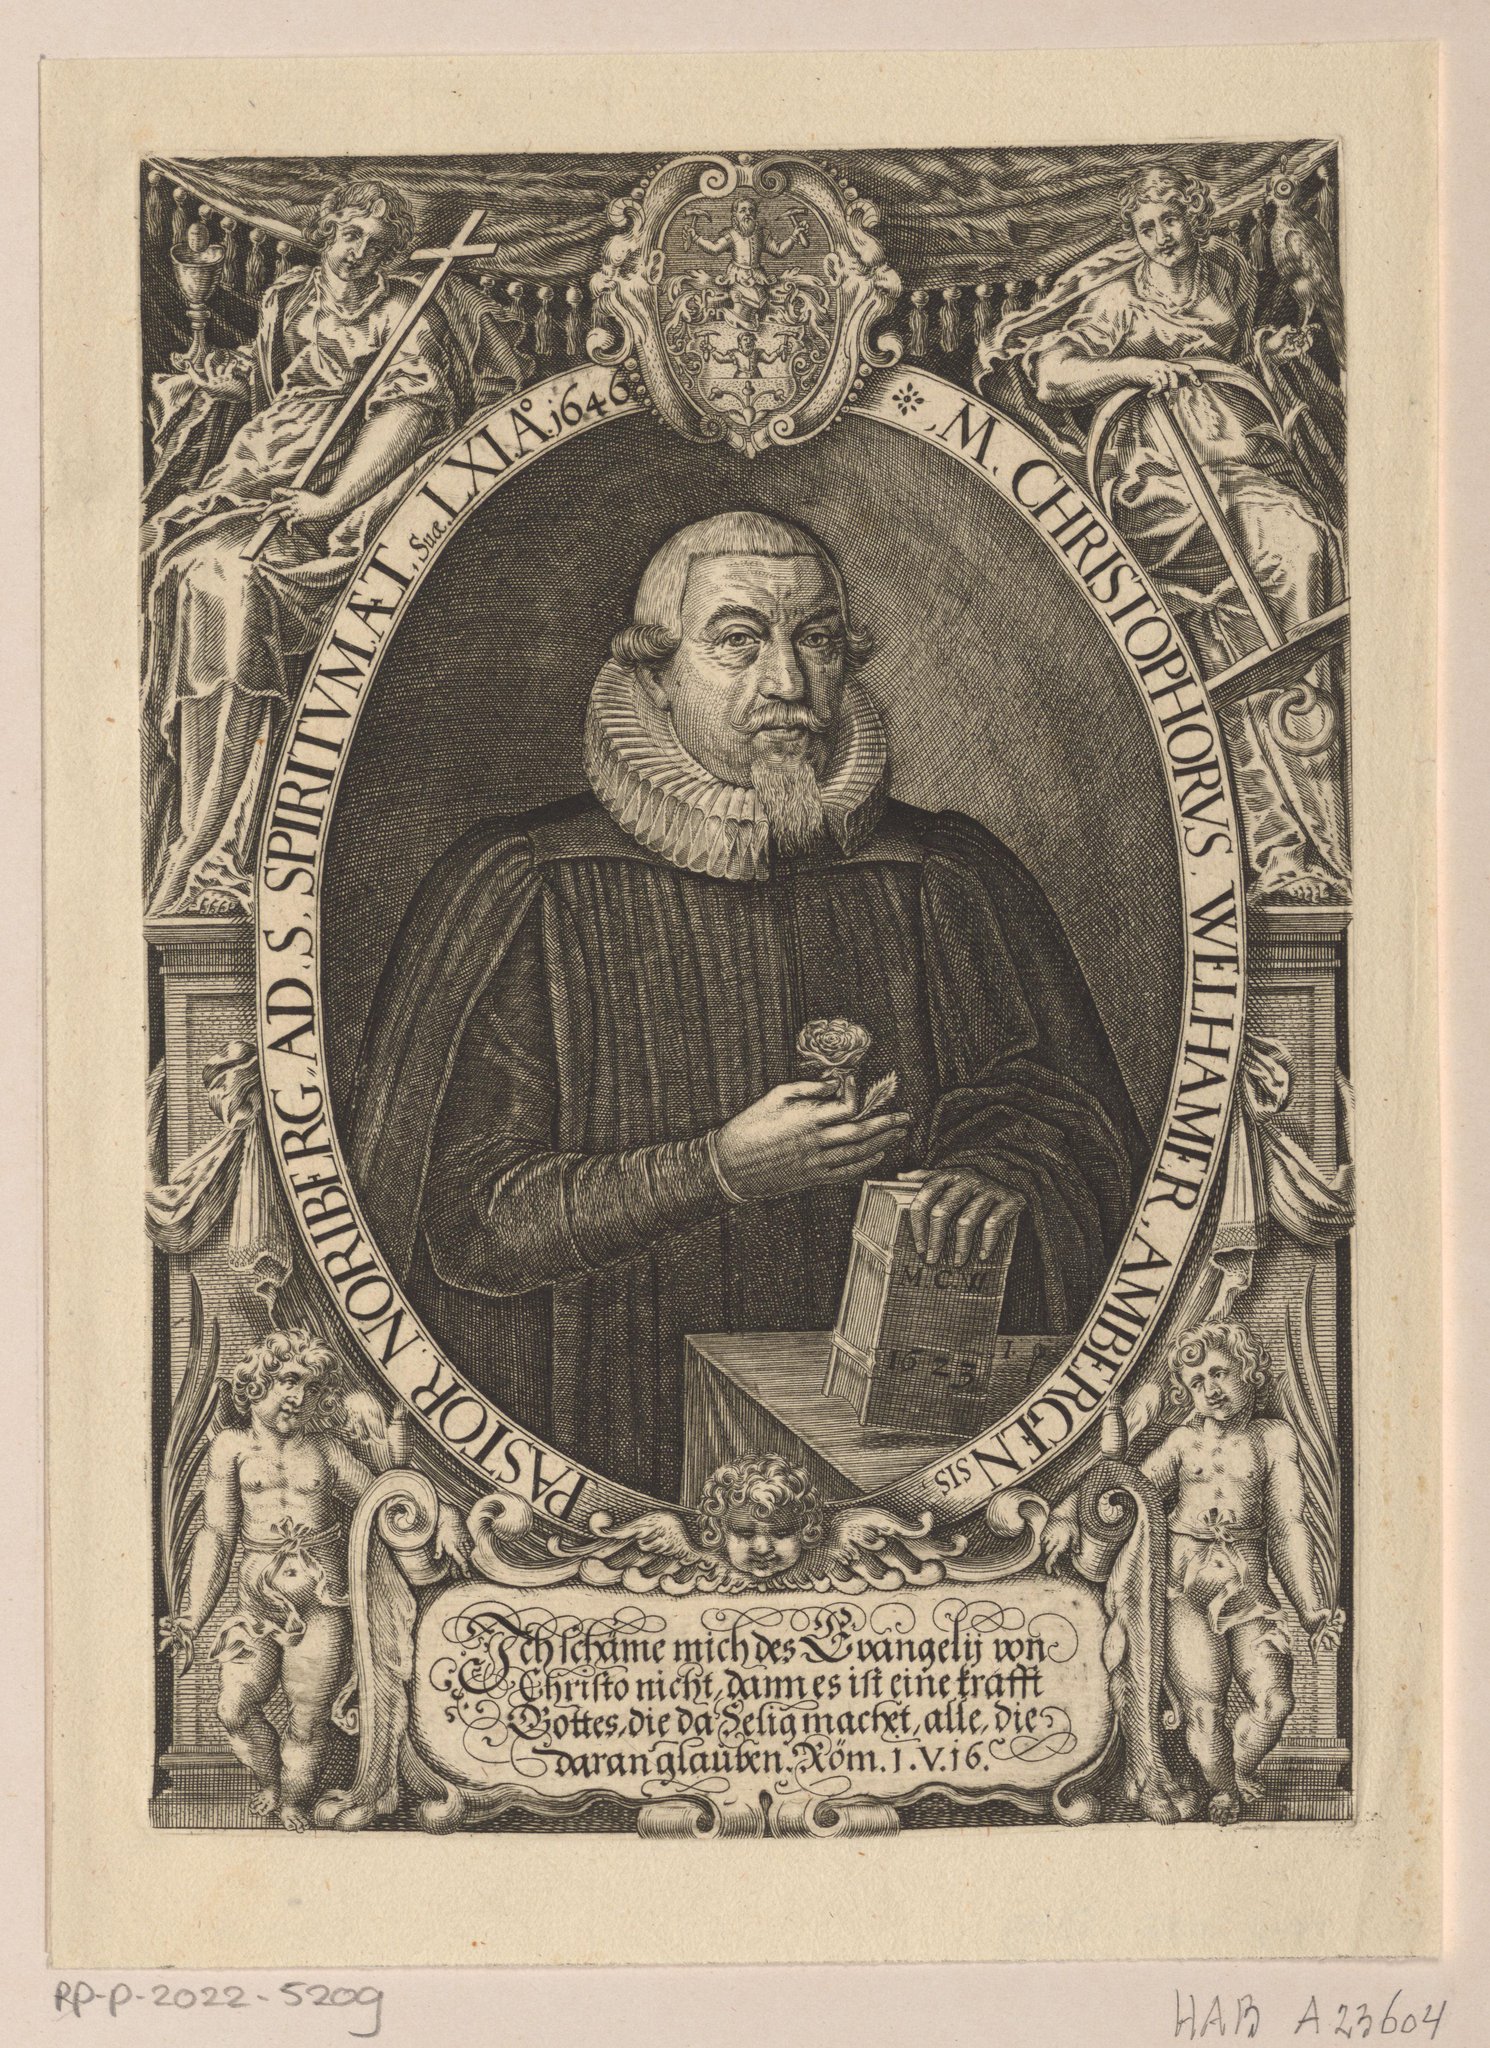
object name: print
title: Portret van Christoph Welhamer op 61-jarige leeftijd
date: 1646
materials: paper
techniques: engraving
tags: amberg, fides (faith) as roman personification, historical persons, book, hope; 'speranza', 'speranza delle fatiche' (ripa), flowers: rose, cupids: 'amores', 'amoretti', 'putti', armorial bearing, heraldry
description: Met vierregelig onderschrift in het Duits.